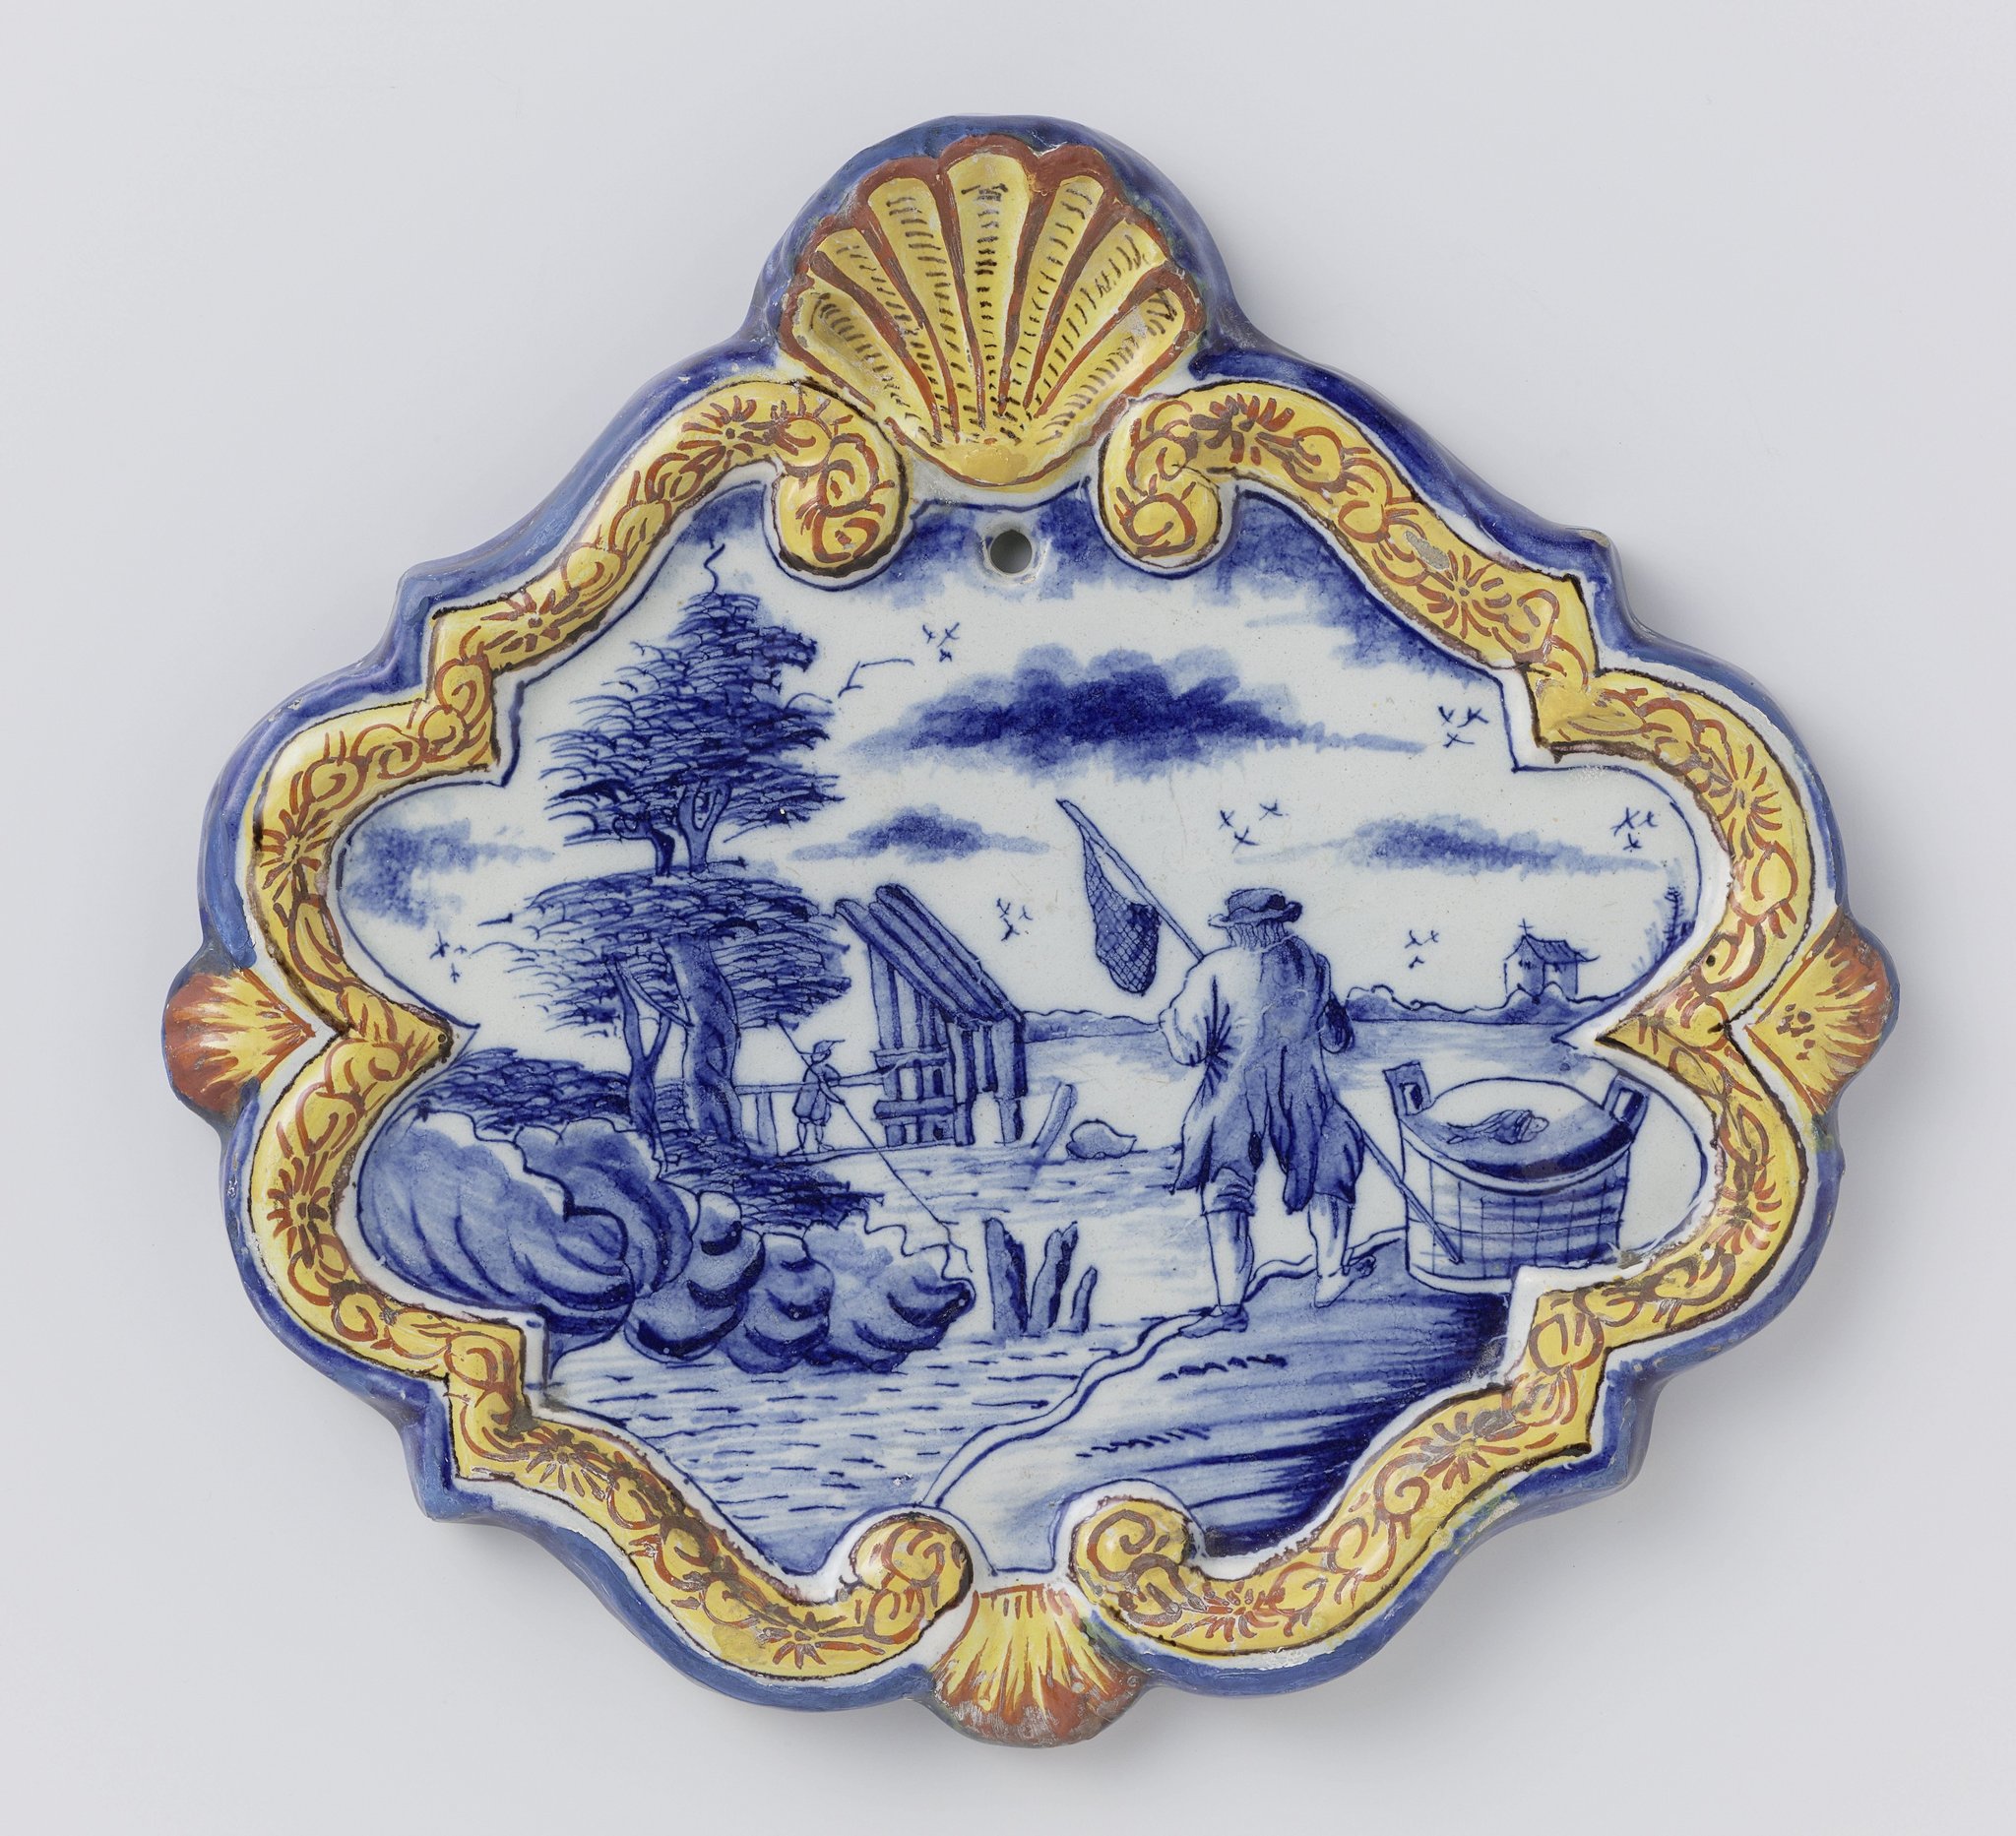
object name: plate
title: Ruitvormige plaat van faïence met vissers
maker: Anonymous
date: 1750-1775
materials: faience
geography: delft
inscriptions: inscription: ‘1.’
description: Plaat van faïence, ruitvormig. Beschilderd in blauw met een waterlandschap met vissers, binnen een veelkleurige rand.